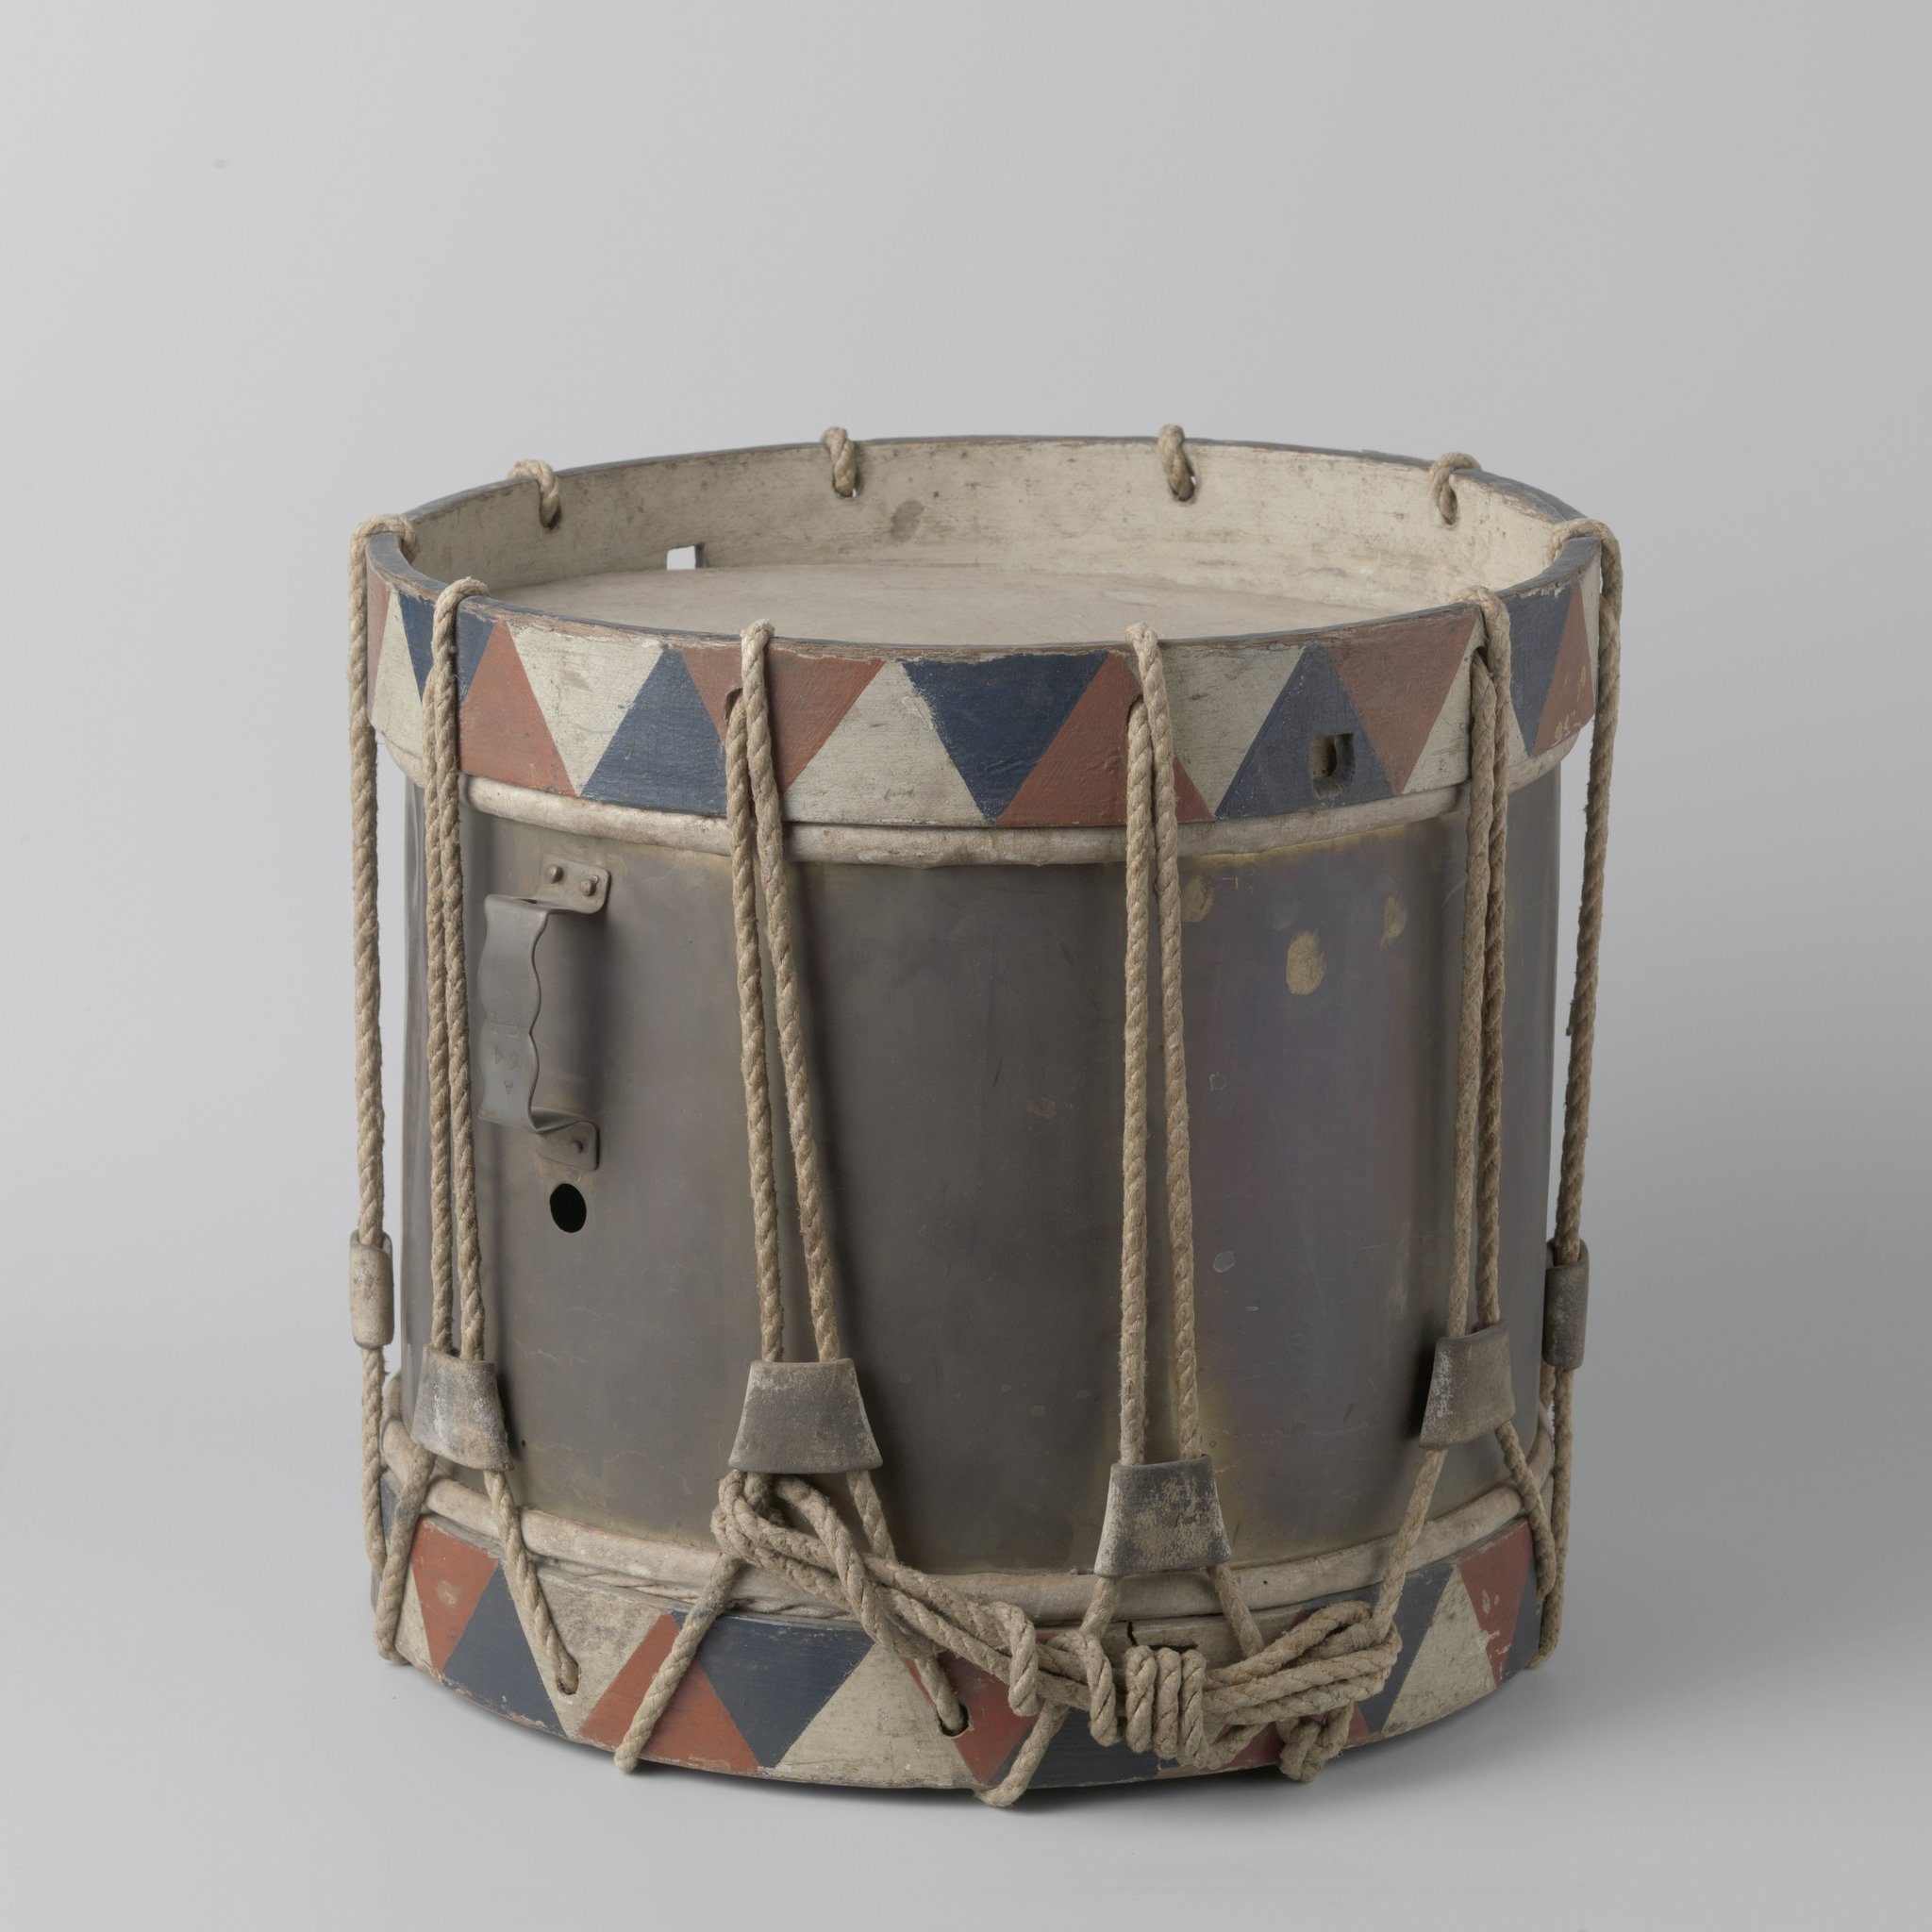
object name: drum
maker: Anonymous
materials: brass, leather, fiber, wood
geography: netherlands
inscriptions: inscription: ‘1855-30’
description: Music has always been a crucial element of public celebrations, such as military parades, coronations, royal weddings, and funerals, adding grandeur to the solemnity of the occasion. Musical ensembles entrusted with performing music at these events have existed in Europe since the Middle Ages. This display highlights various marching bands and their musical instruments dating from the 16th to the 19th century.